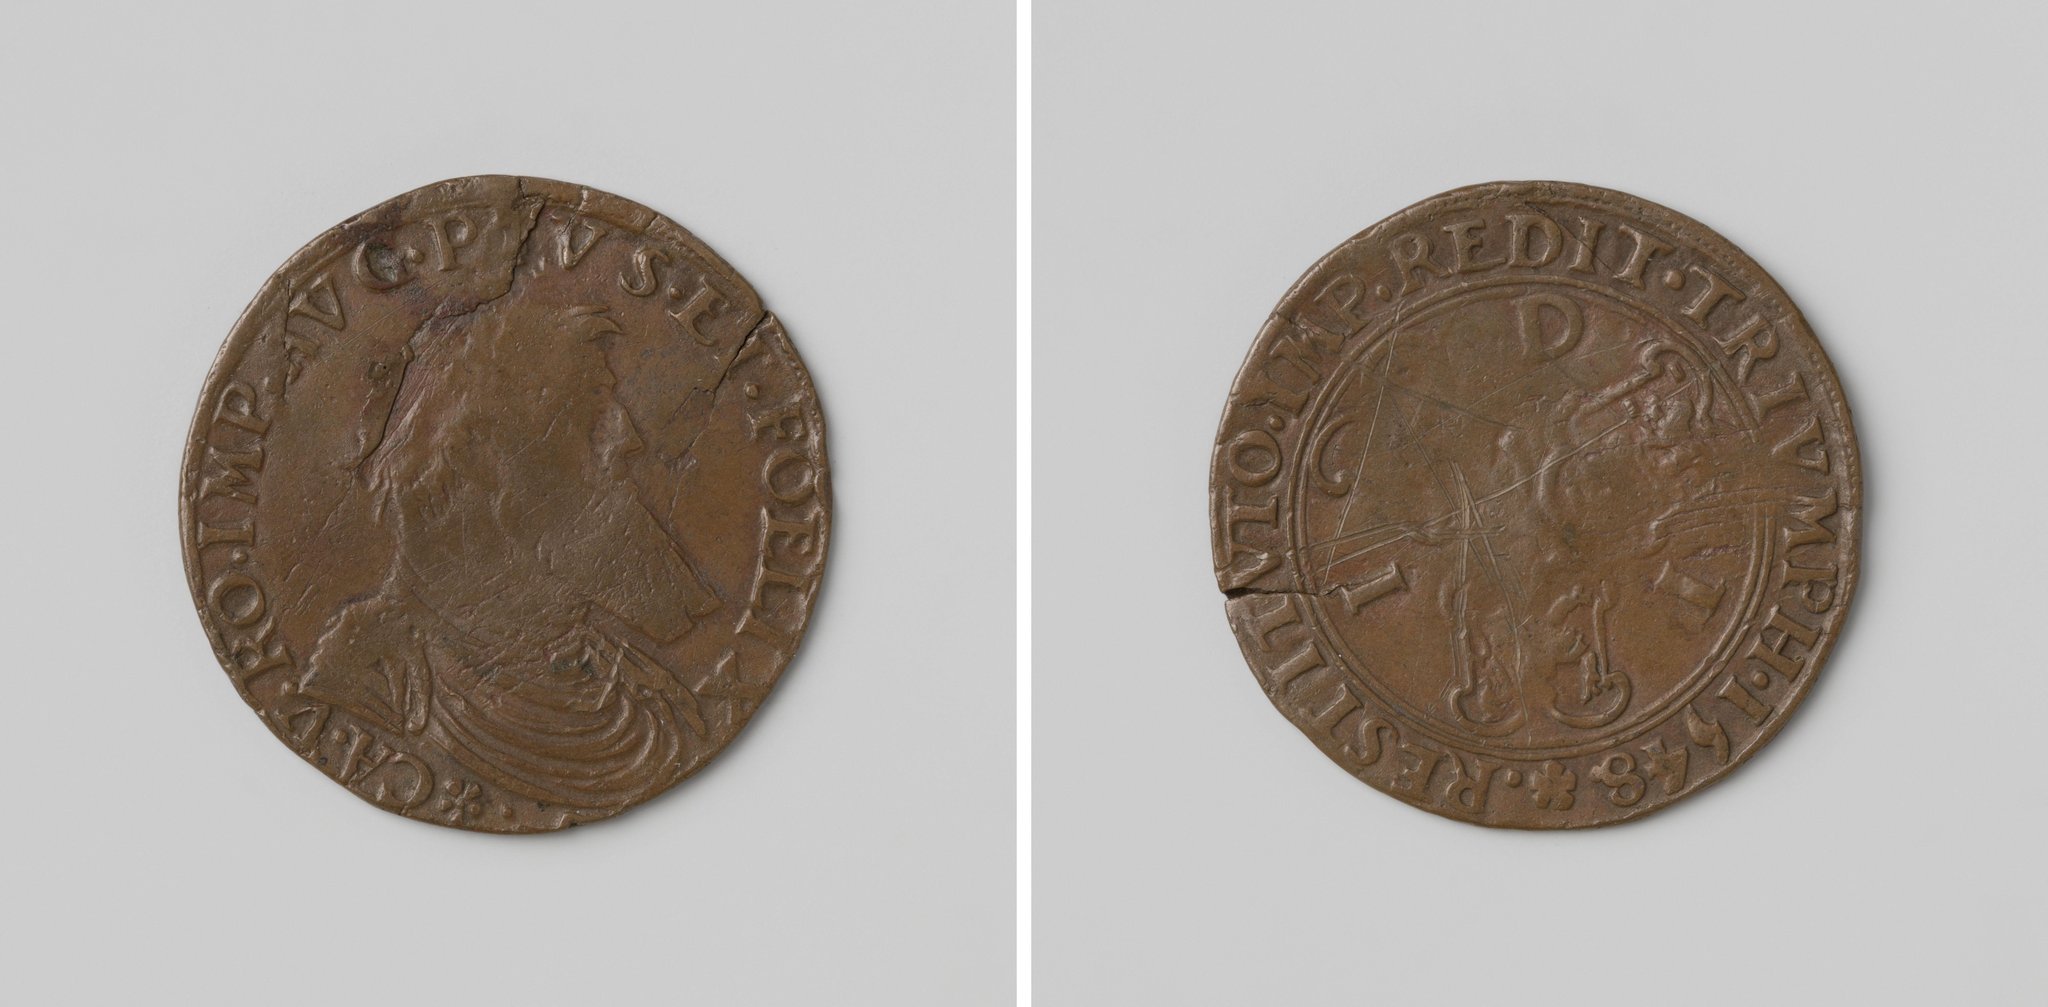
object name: jeton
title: Herstel van de vrede in Duitsland op het Interim van Augsburg, rekenpenning ten behoeve van Mr. Jacob de Jonge, auditeur van de rekenkamer van Holland te 's-Gravenhage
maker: Anonymous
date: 1548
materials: copper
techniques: striking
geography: netherlands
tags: ghent, charles v (holy roman emperor and king of spain), the hague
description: Koperen penning. Voorzijde: borststuk man met lauwerkrans binnen omschrift. Keerzijde: drie in kring geplaatste wapenschilden; daartussen letters I, D en I binnen omschrift